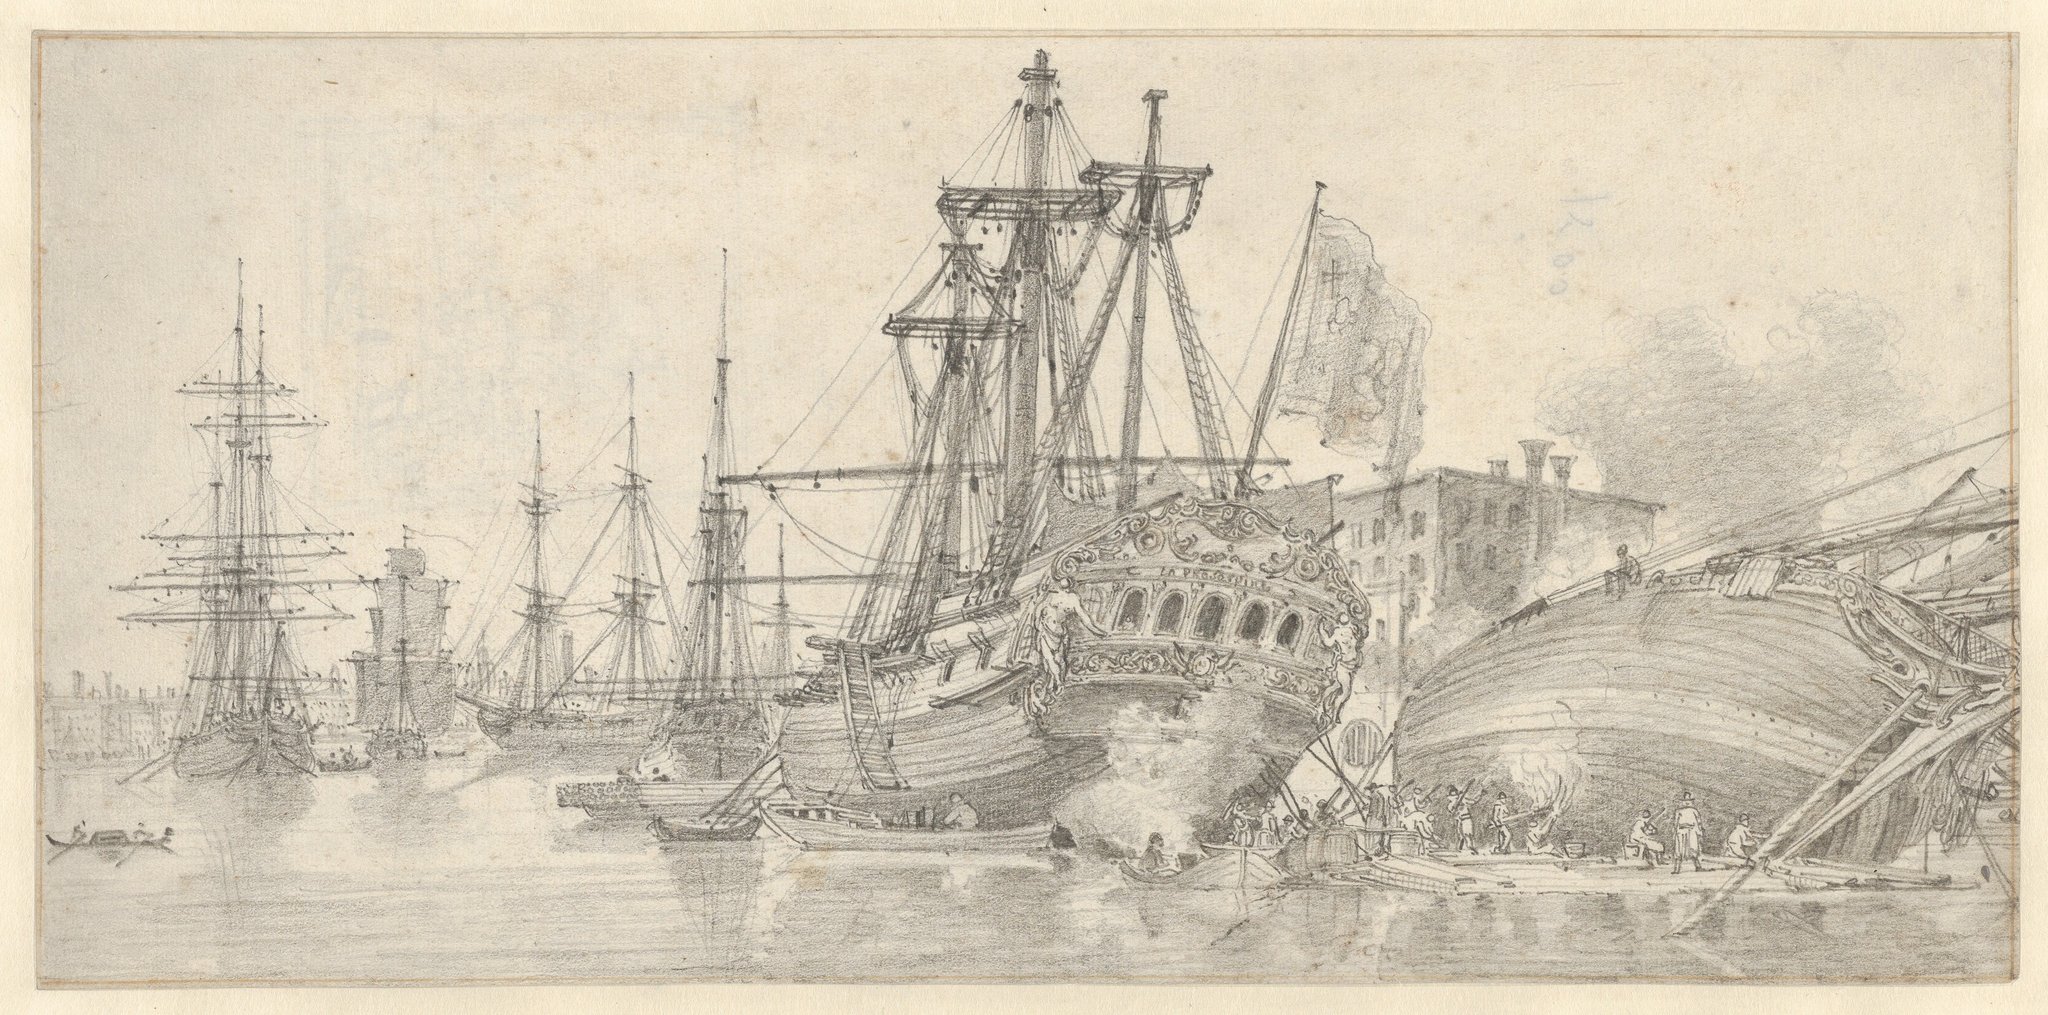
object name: drawing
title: The Proserpine at anchor in Venice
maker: louis françois cassas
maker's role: artist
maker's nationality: french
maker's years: 1756-1827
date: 1782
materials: chalk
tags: ships,venice